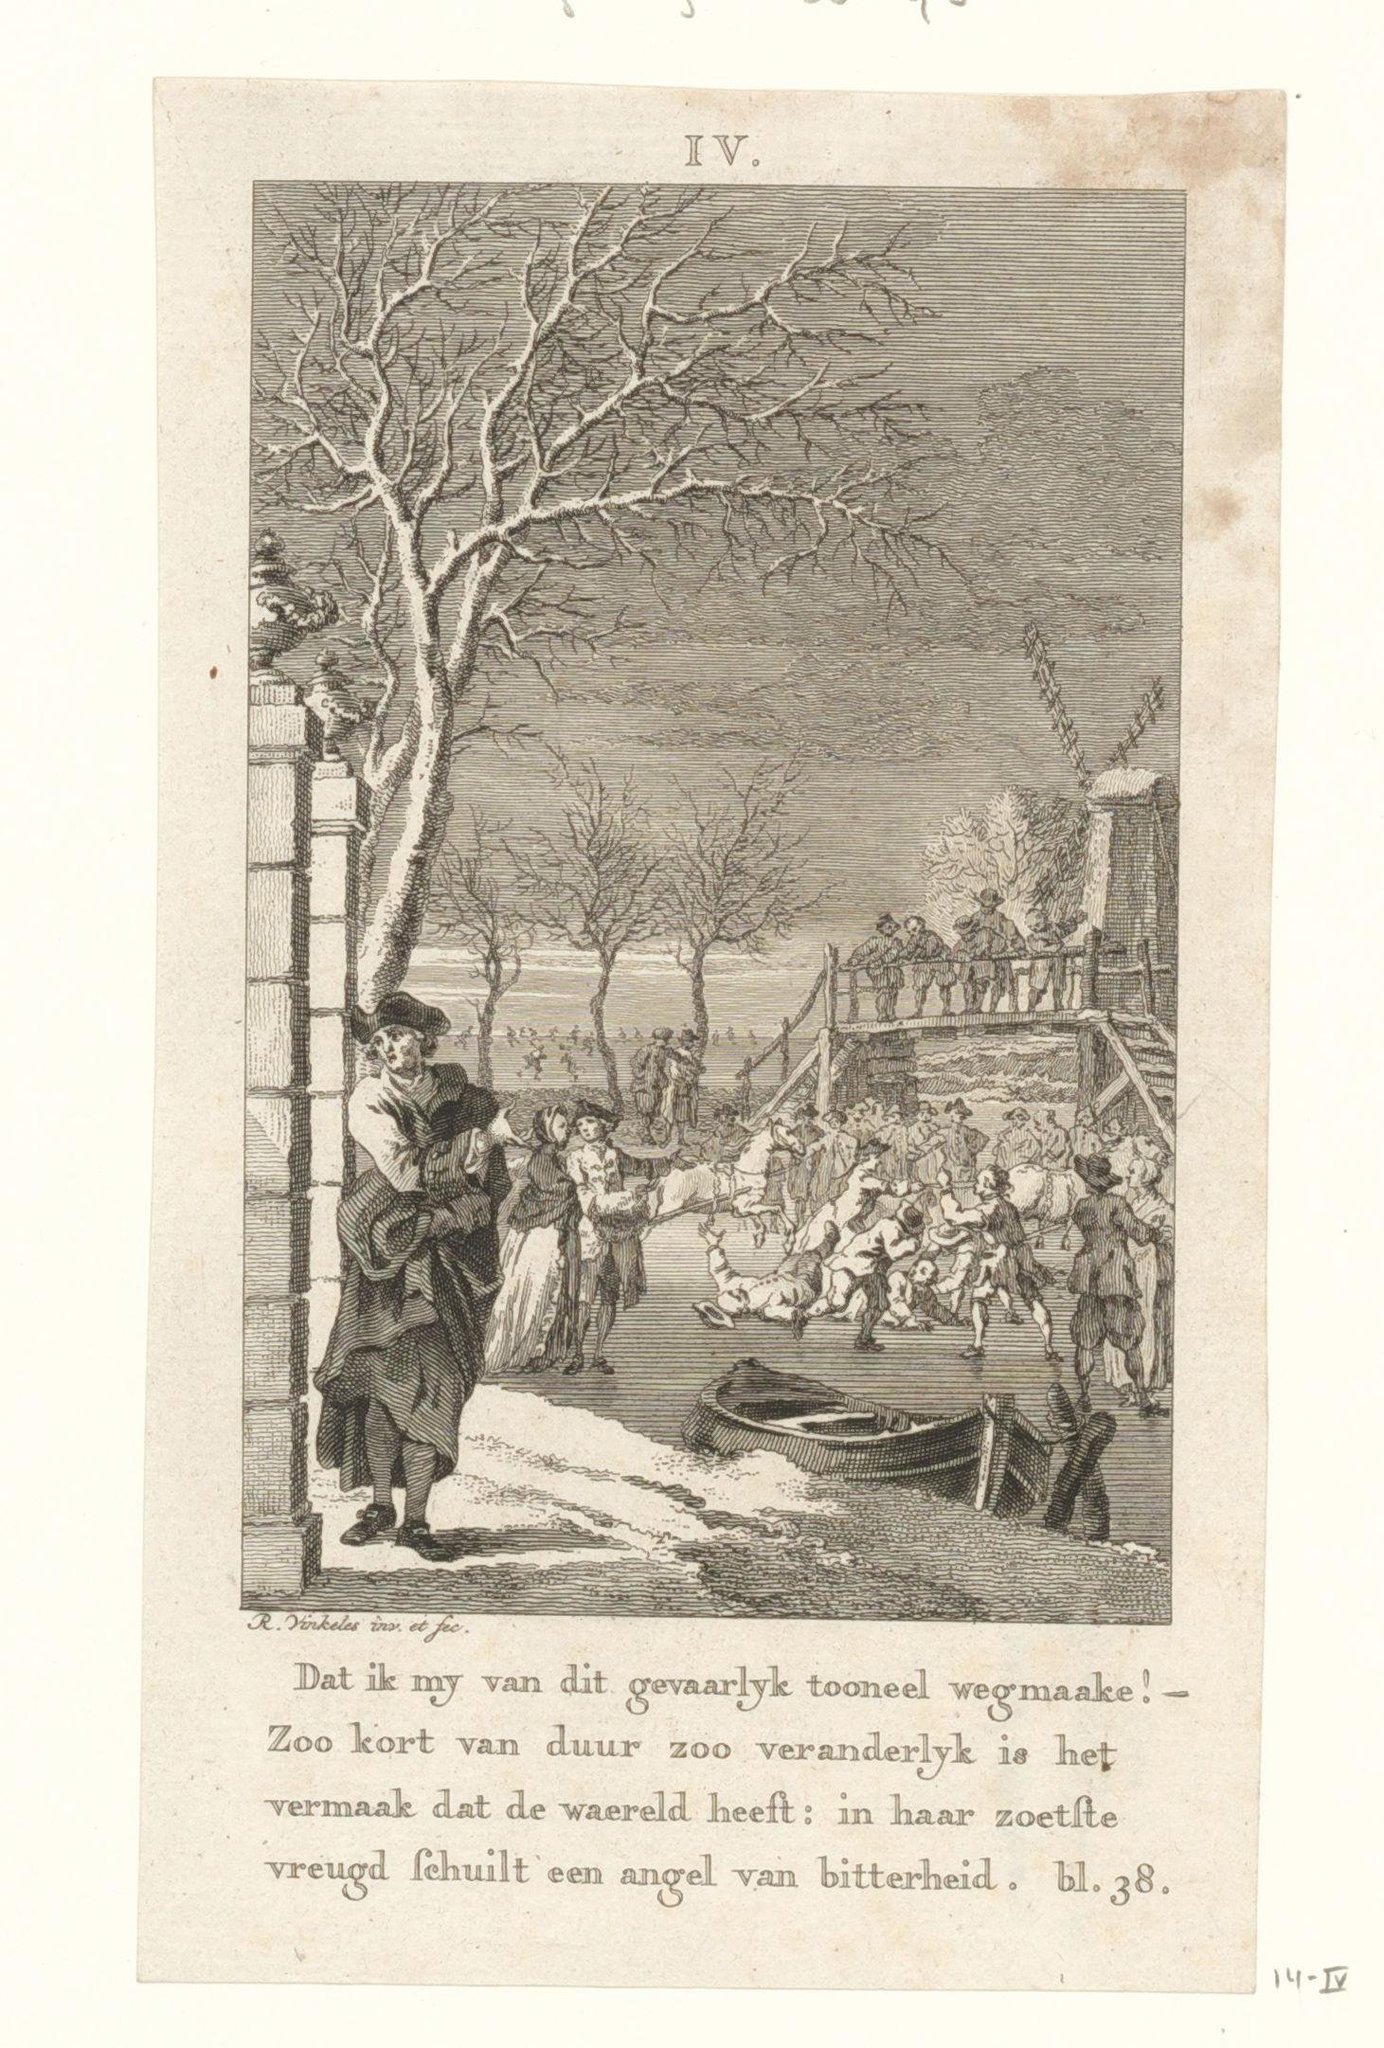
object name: print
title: Schaatsen in de winter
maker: reinier vinkeles (i)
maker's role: draughtsman, print maker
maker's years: 1741-1816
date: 1768-1769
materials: paper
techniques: etching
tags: year divided into four seasons, winter landscape; landscape symbolizing winter (the four seasons of the year), skates (winter sports)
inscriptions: stamp, collector's mark: Lugt 1641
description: Prent waarschijnlijk uit: Engelberts, Engelbertus Matthias. Proeve van bespiegelingen in de Lente (...). Amsterdam: Yntema & Tieboel, 1768, dl. 1. Of uit: Engelberts, Engelbertus Matthias. Bespiegelingen over de Vier Getyden des Jaars. Amsterdam: Yntema & Tieboel, 1769.